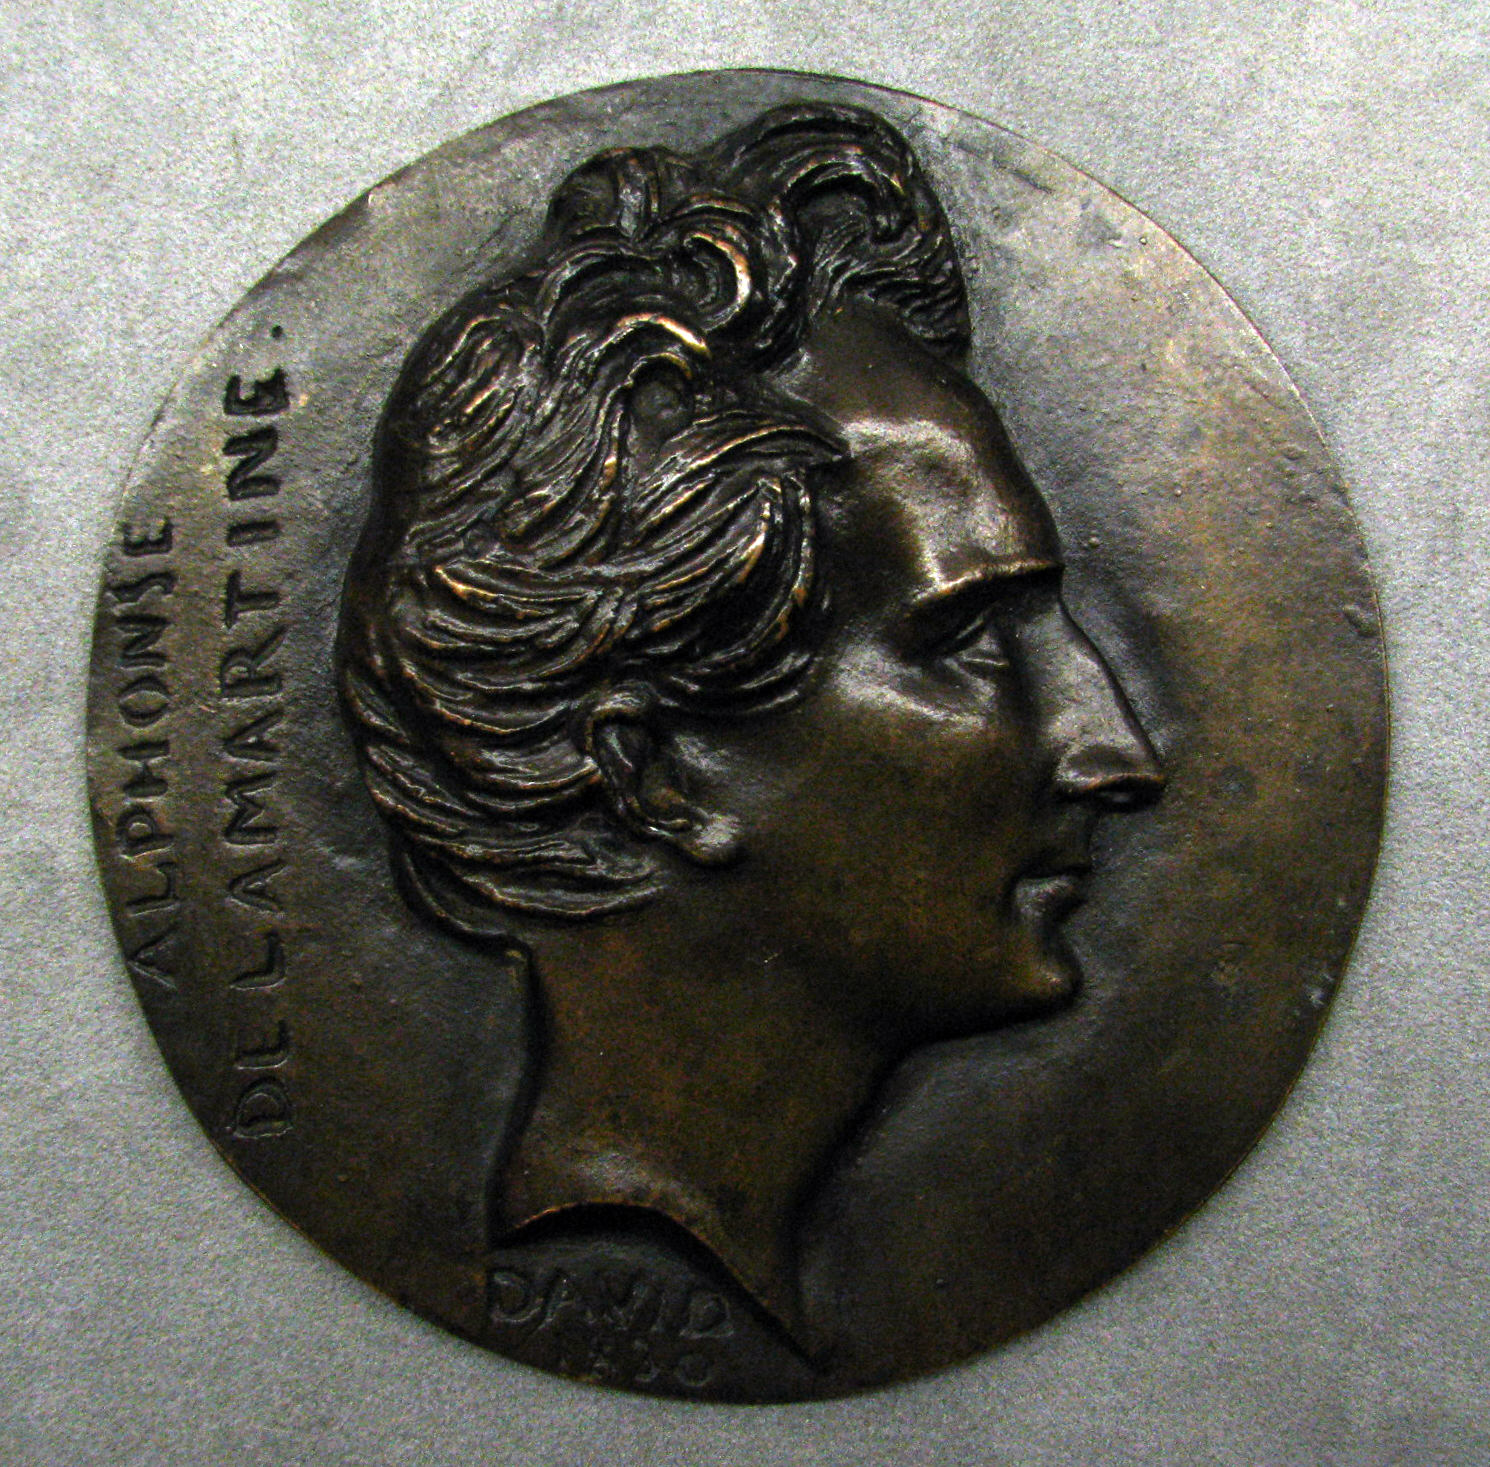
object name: medallion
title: Alphonse de Lamartine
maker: pierre jean david d'angers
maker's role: maker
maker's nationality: french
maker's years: 1788-1856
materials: bronze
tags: men,profiles